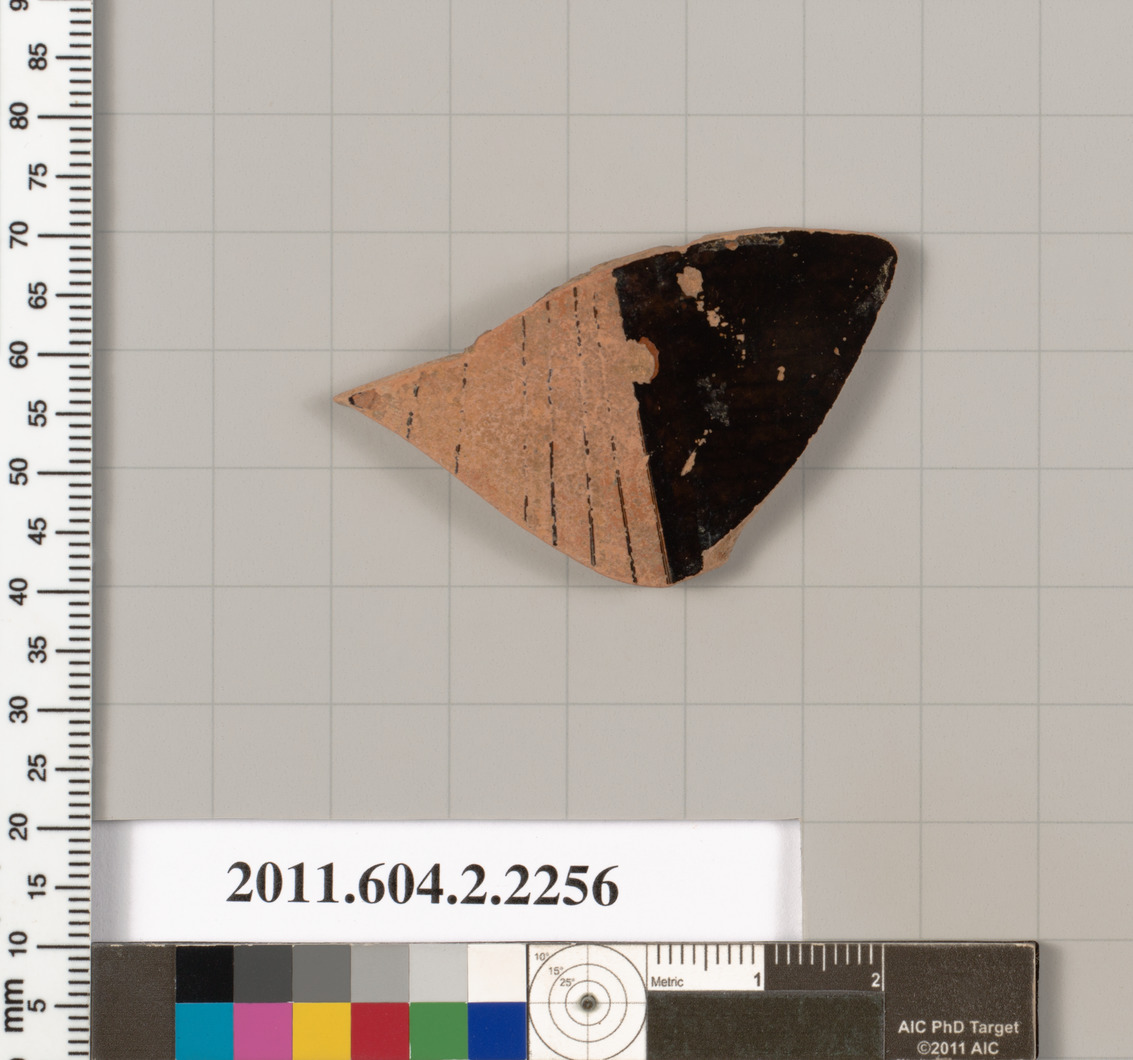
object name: pot fragment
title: Terracotta fragment of a pot; unglazed on the inside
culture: greek, attic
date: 475-451 BCE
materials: terracotta